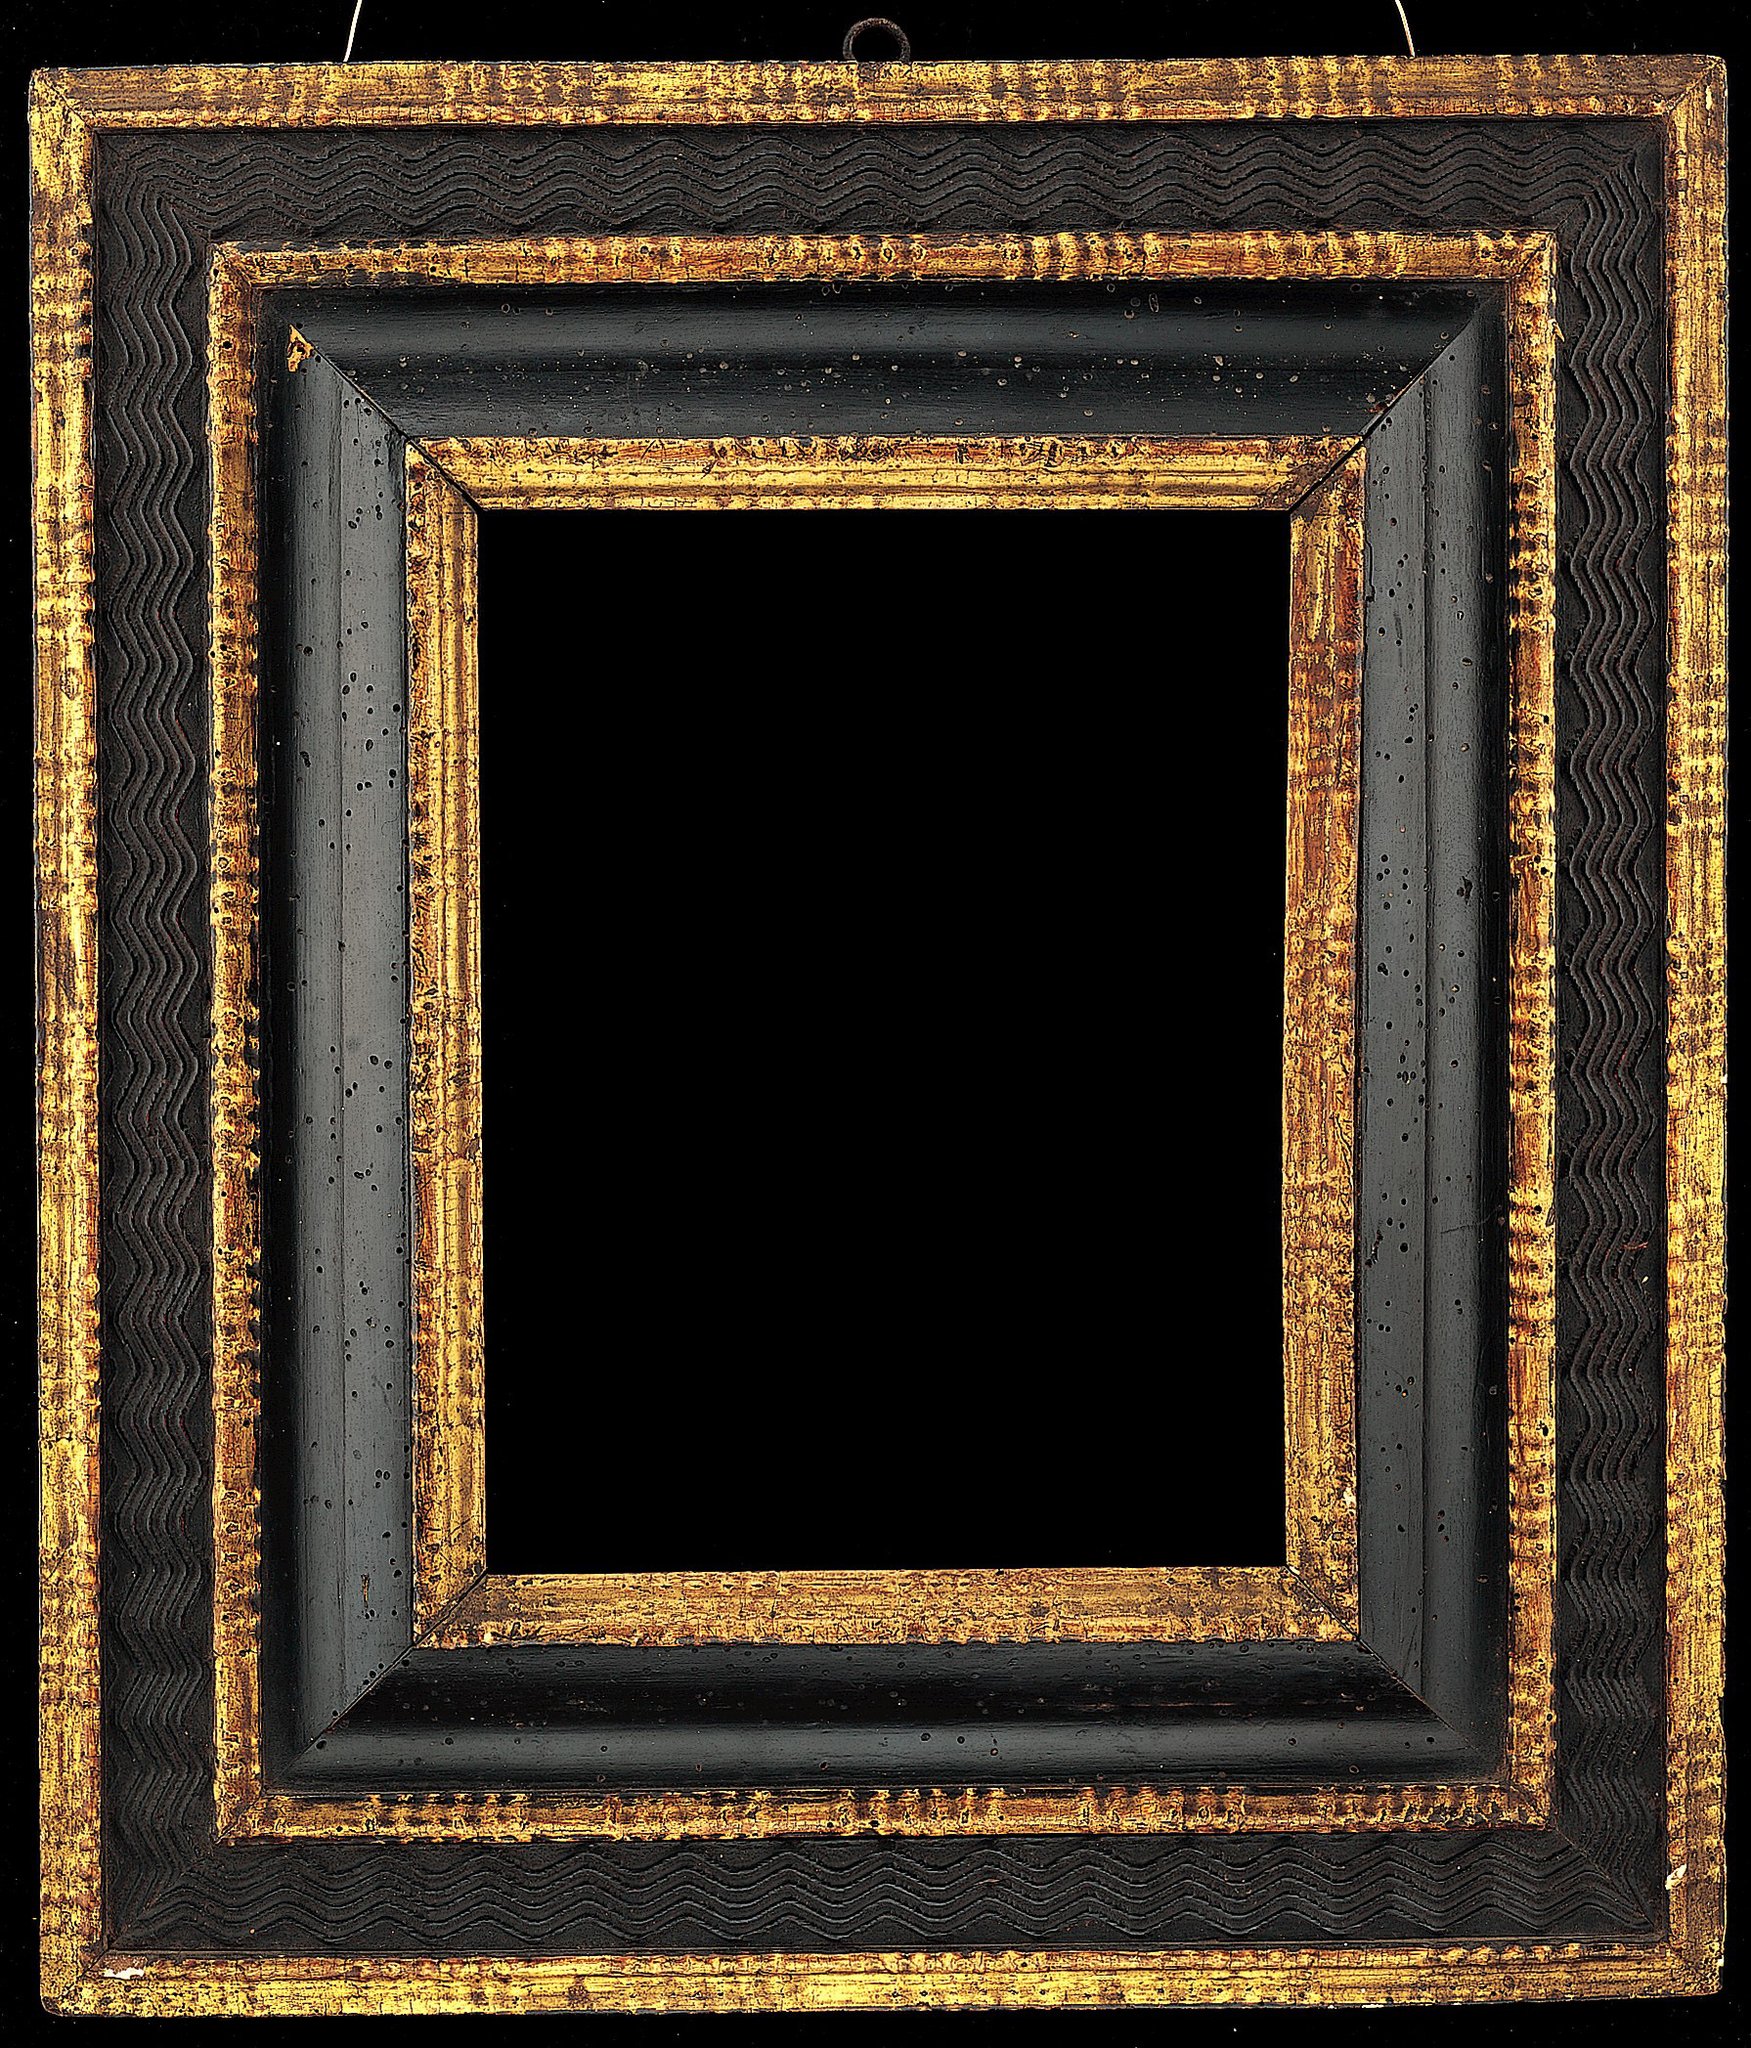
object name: frame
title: Reverse ripple frame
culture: southern italian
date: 1667-1733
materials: wood